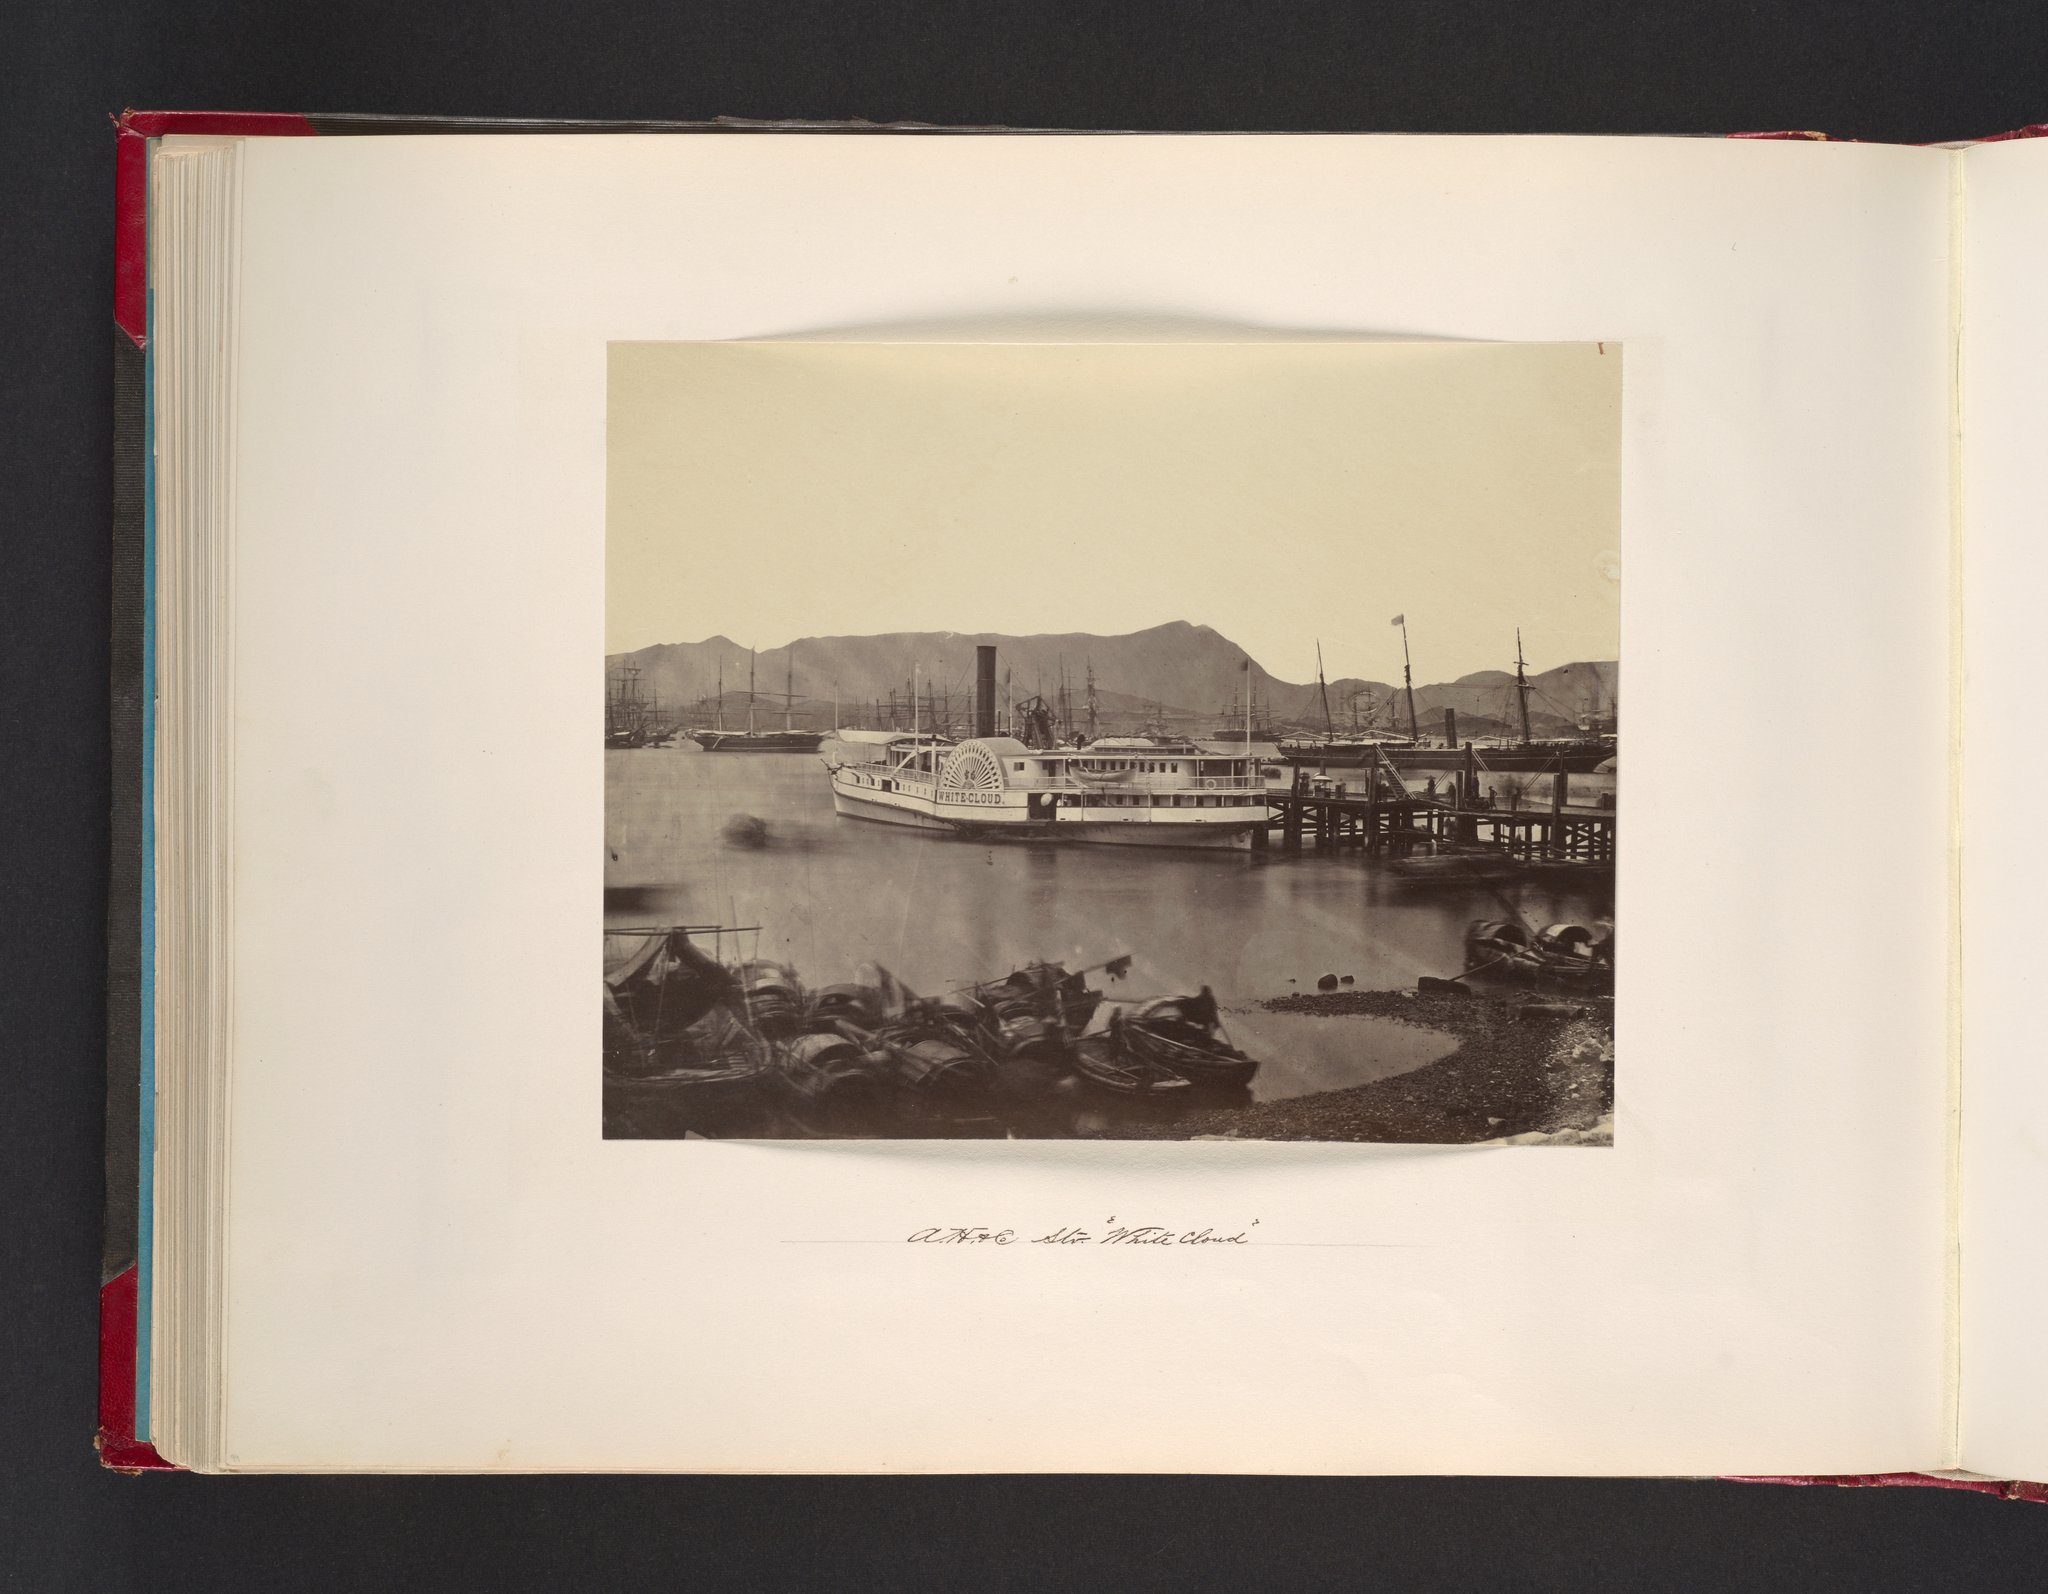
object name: photograph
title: Augustine Heard & Co. Steamer "White Cloud"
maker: john thomson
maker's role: artist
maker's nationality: british, scottish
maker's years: 1837-1921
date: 1865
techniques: albumen silver print, glass negative